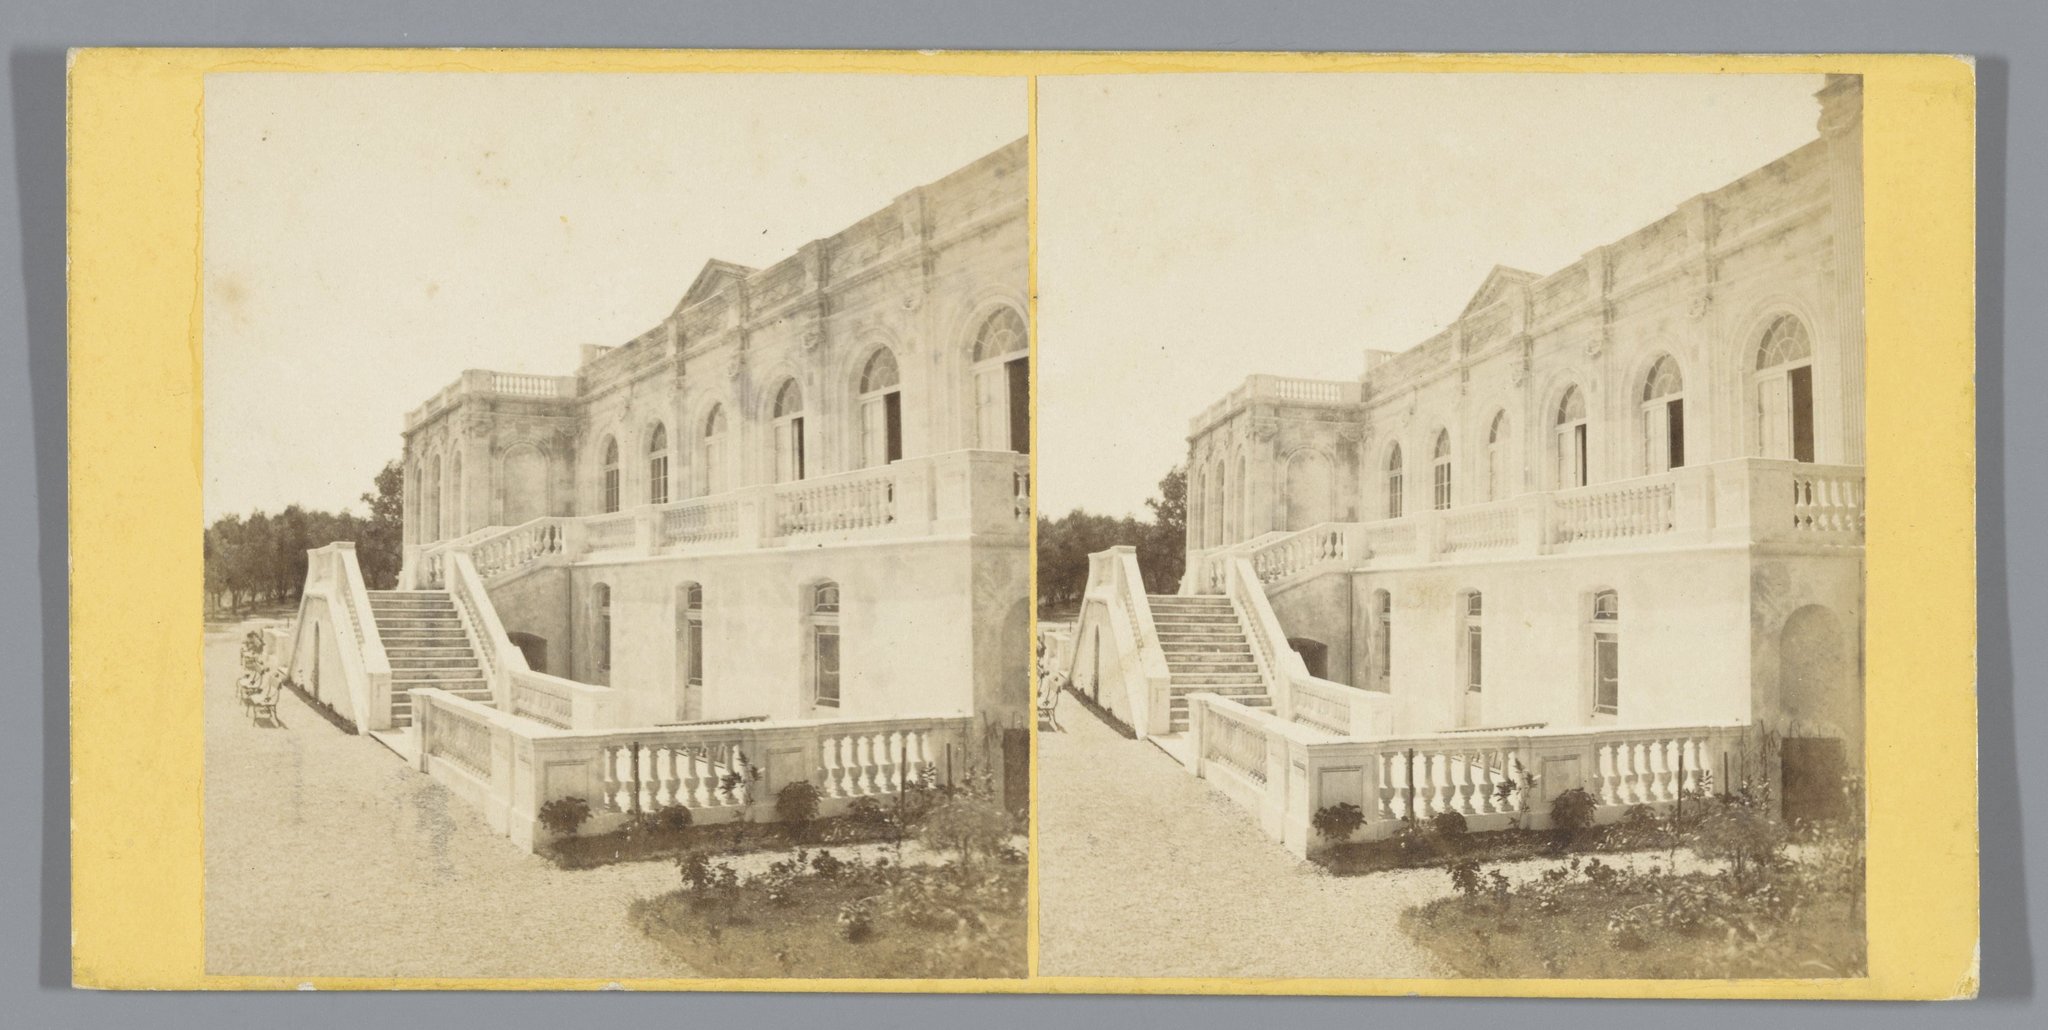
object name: stereograph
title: Casino à Monaco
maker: Anonymous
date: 1850-1880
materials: cardboard, photographic support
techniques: albumen print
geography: monaco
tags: casino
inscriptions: number: ‘567’